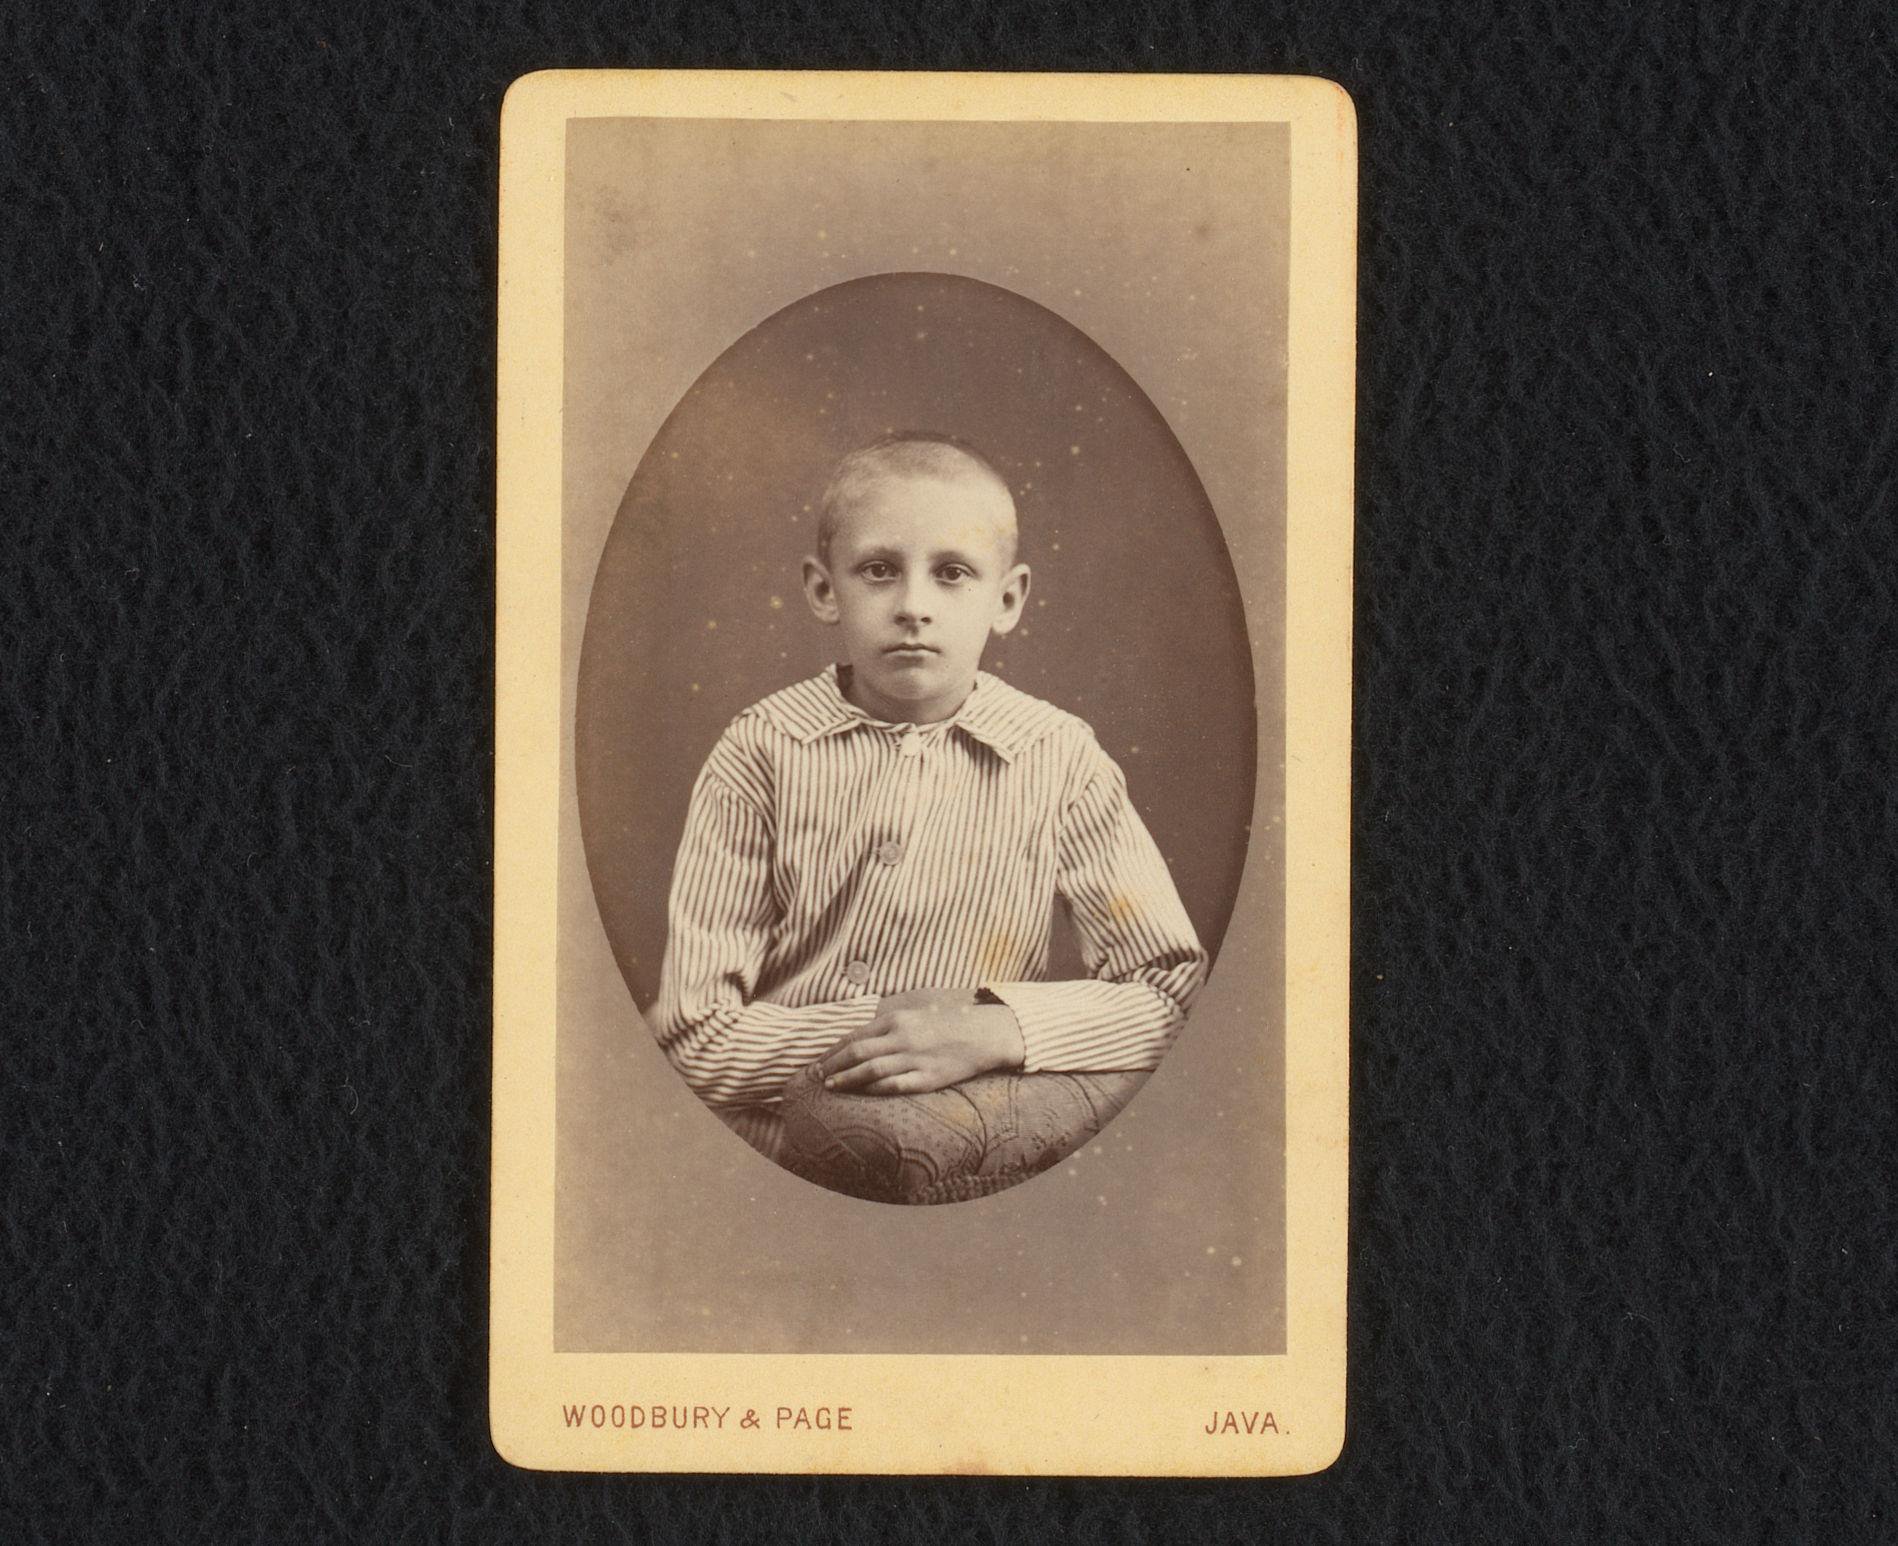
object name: photograph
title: Portret van J. Heper [?]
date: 1885-1895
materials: cardboard, paper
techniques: albumen print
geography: java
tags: historical persons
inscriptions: inscription: ‘J. Heper. Pz. [?]/ 1883 10/01’